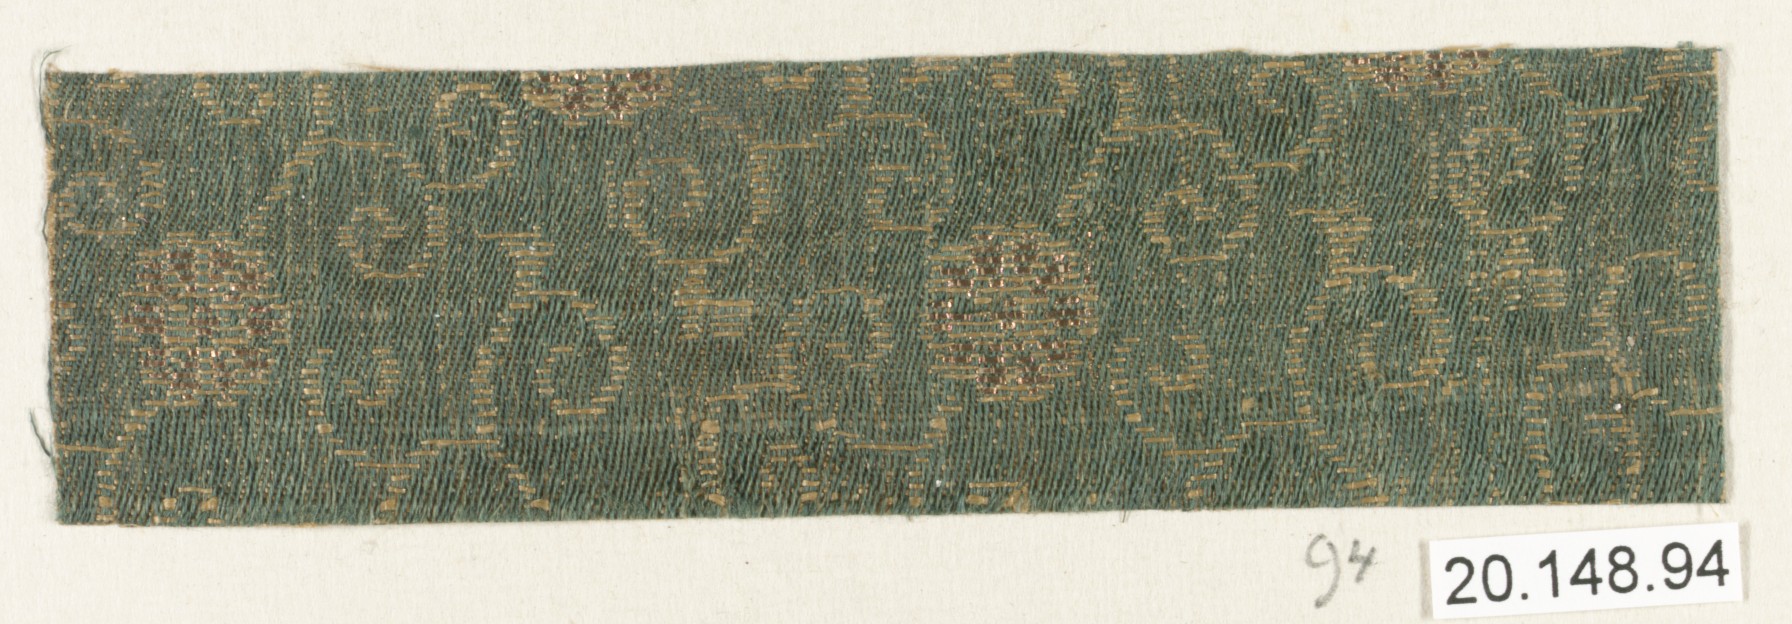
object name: piece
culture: japanese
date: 1601-1700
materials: silk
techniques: compound weave